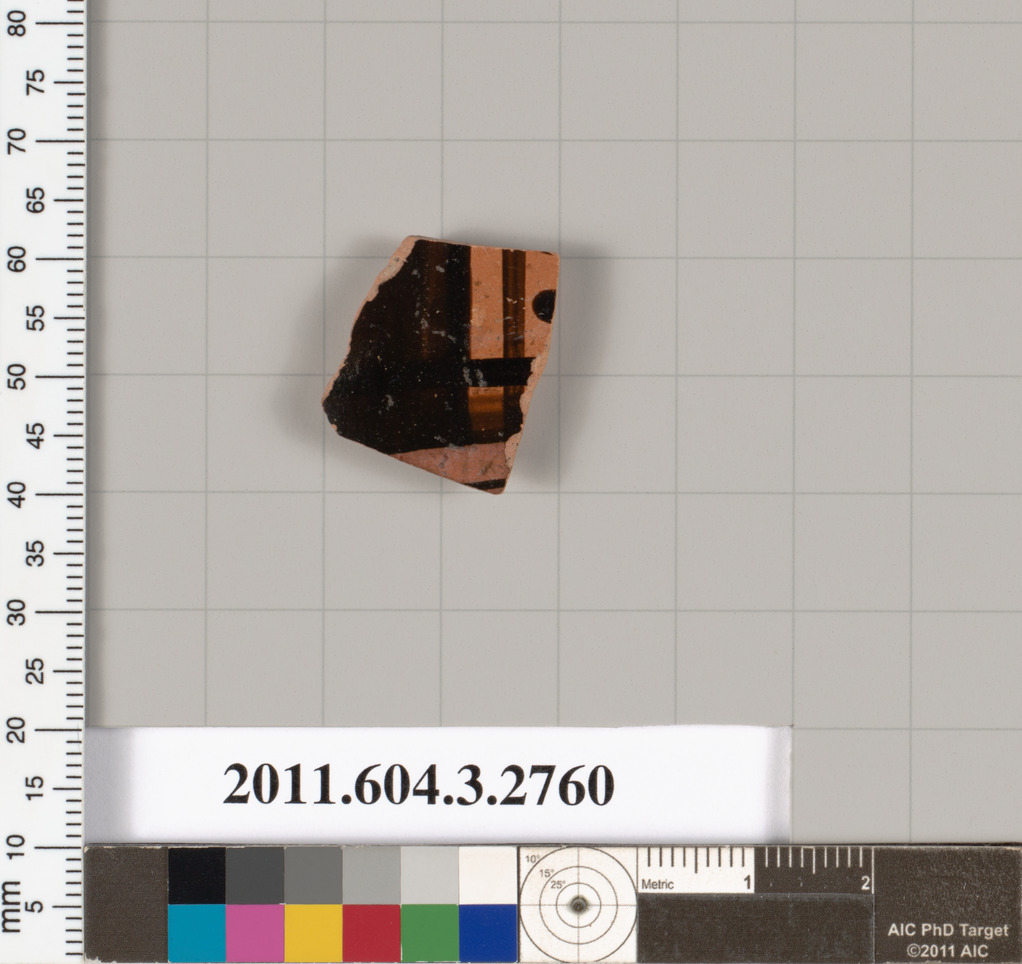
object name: oinochoe fragment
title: Terracotta fragment of an oinochoe (jug)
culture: greek, attic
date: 534-468 BCE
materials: terracotta